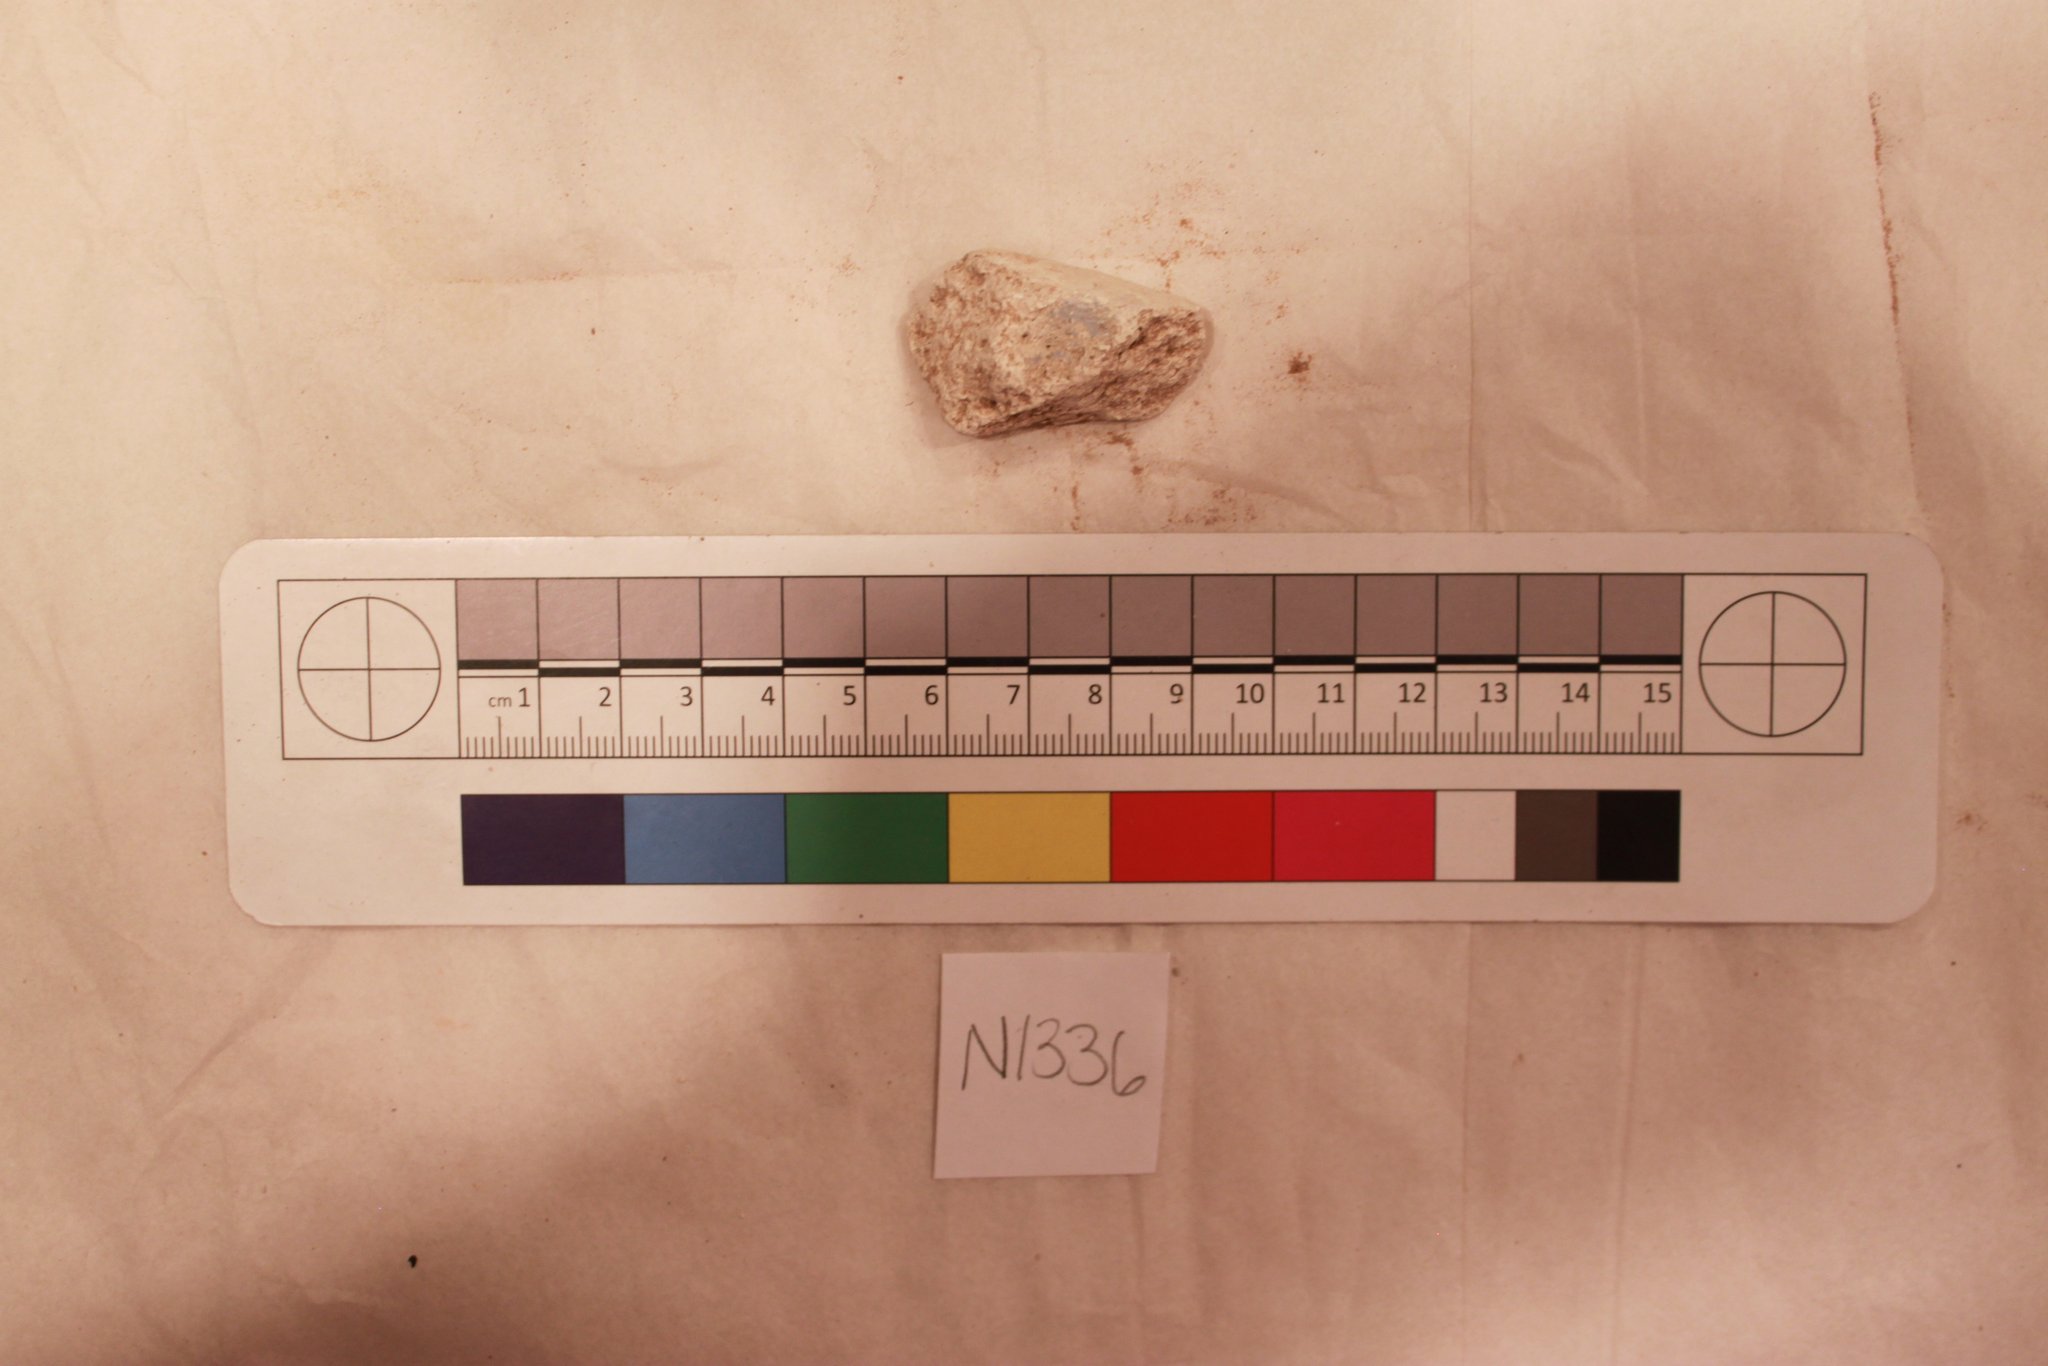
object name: fragment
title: Stucco Fragment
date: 701-1200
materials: plaster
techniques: carving, painting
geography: iran